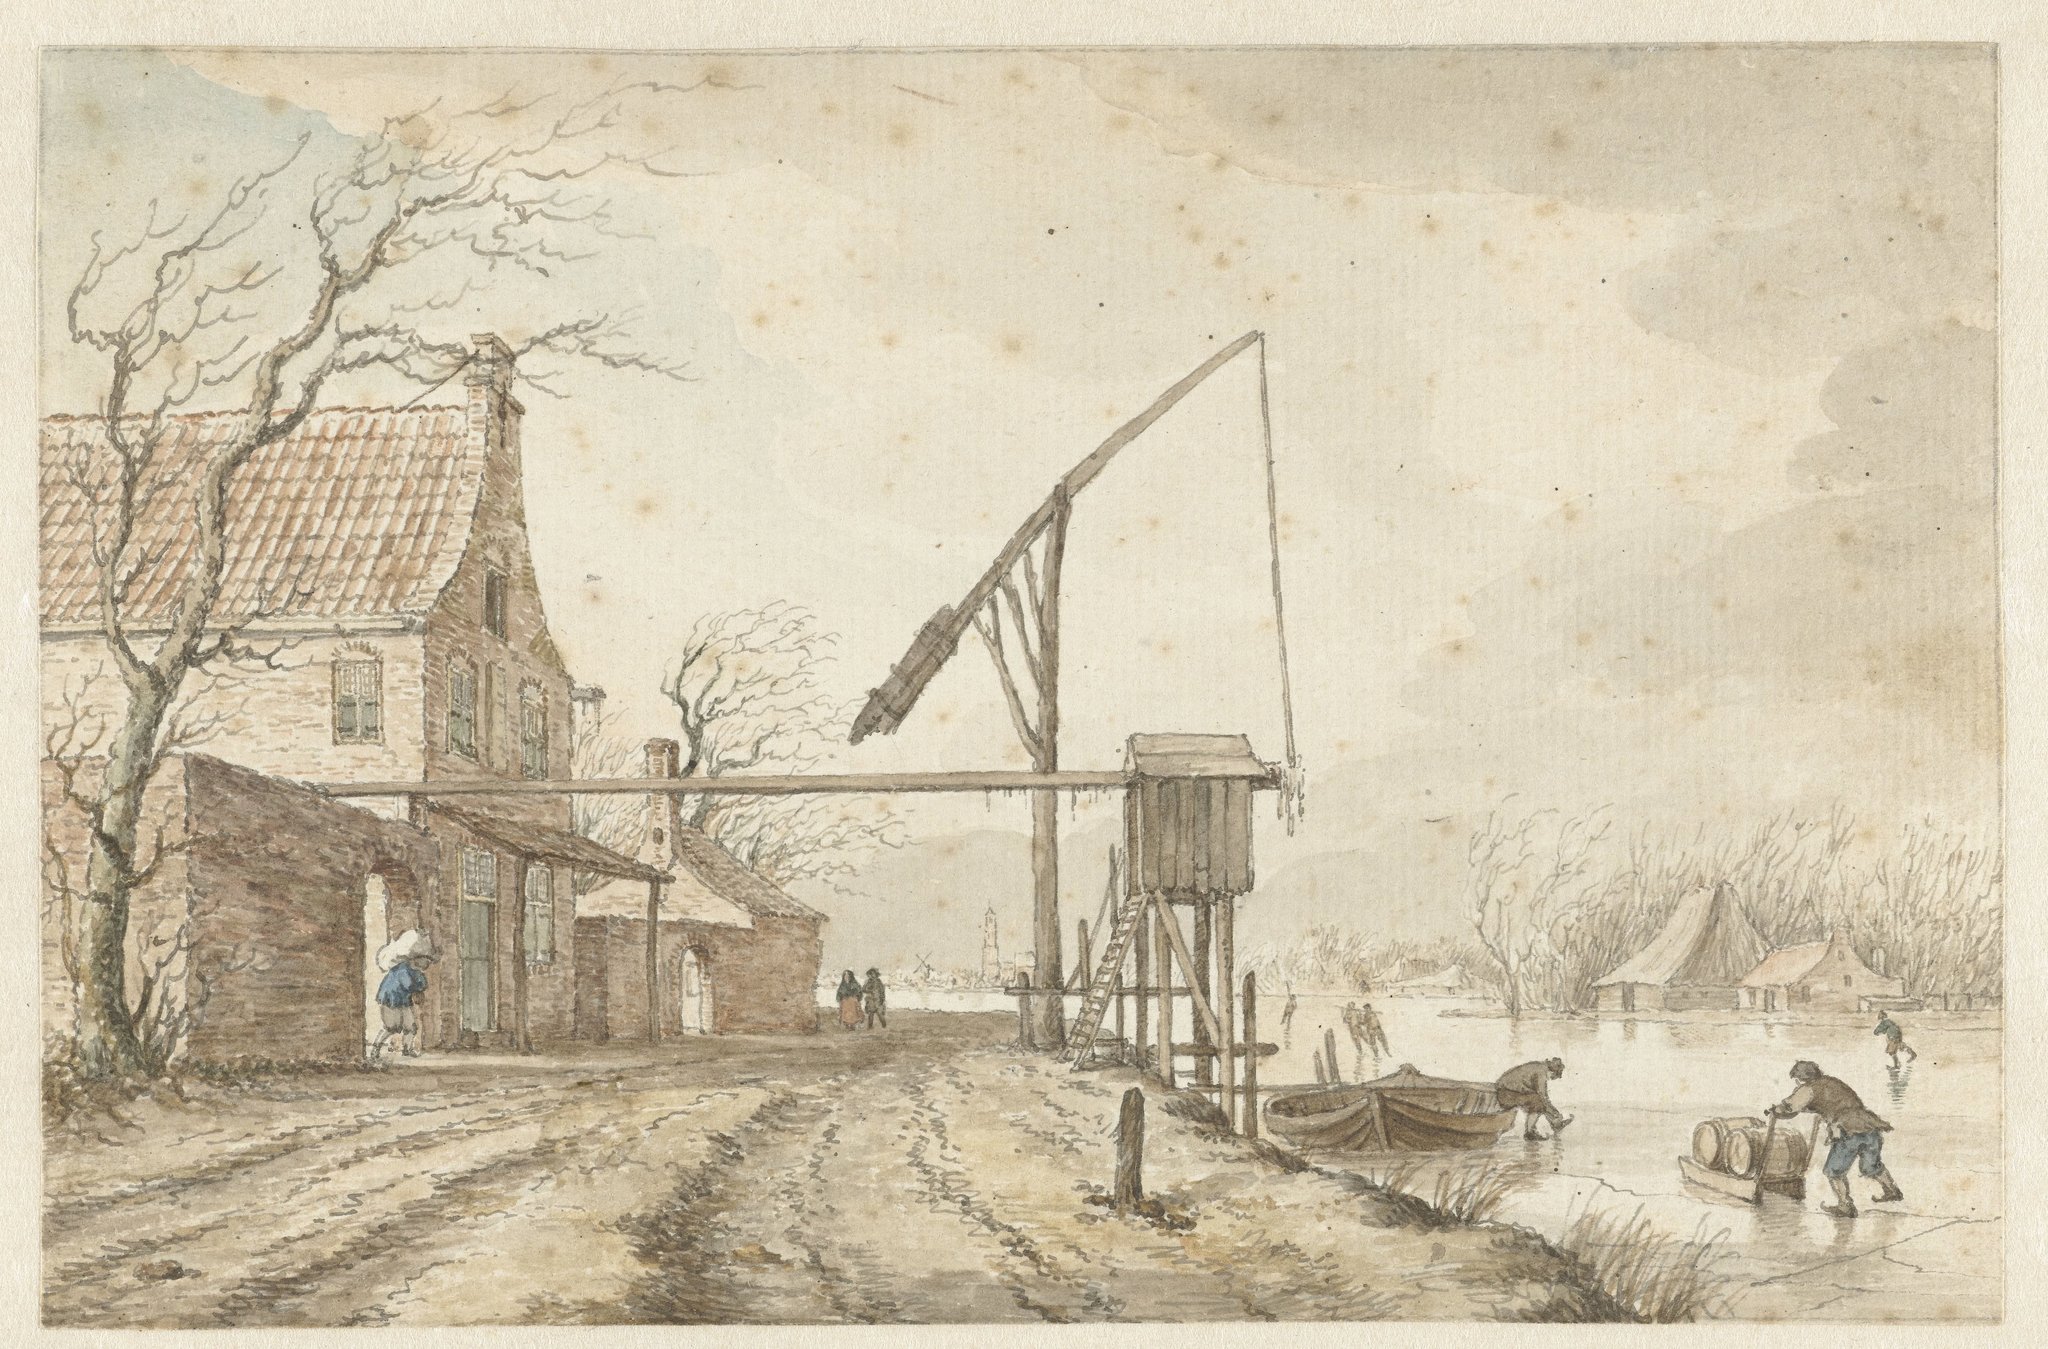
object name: drawing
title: Winterlandschap met huizen en hefboom langs bevroren vaart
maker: jacob cats (1741-1799)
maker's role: draughtsman, print maker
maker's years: 1741-1799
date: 1771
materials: ink, paper, watercolor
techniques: brush, pen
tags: ice ~ freezing weather